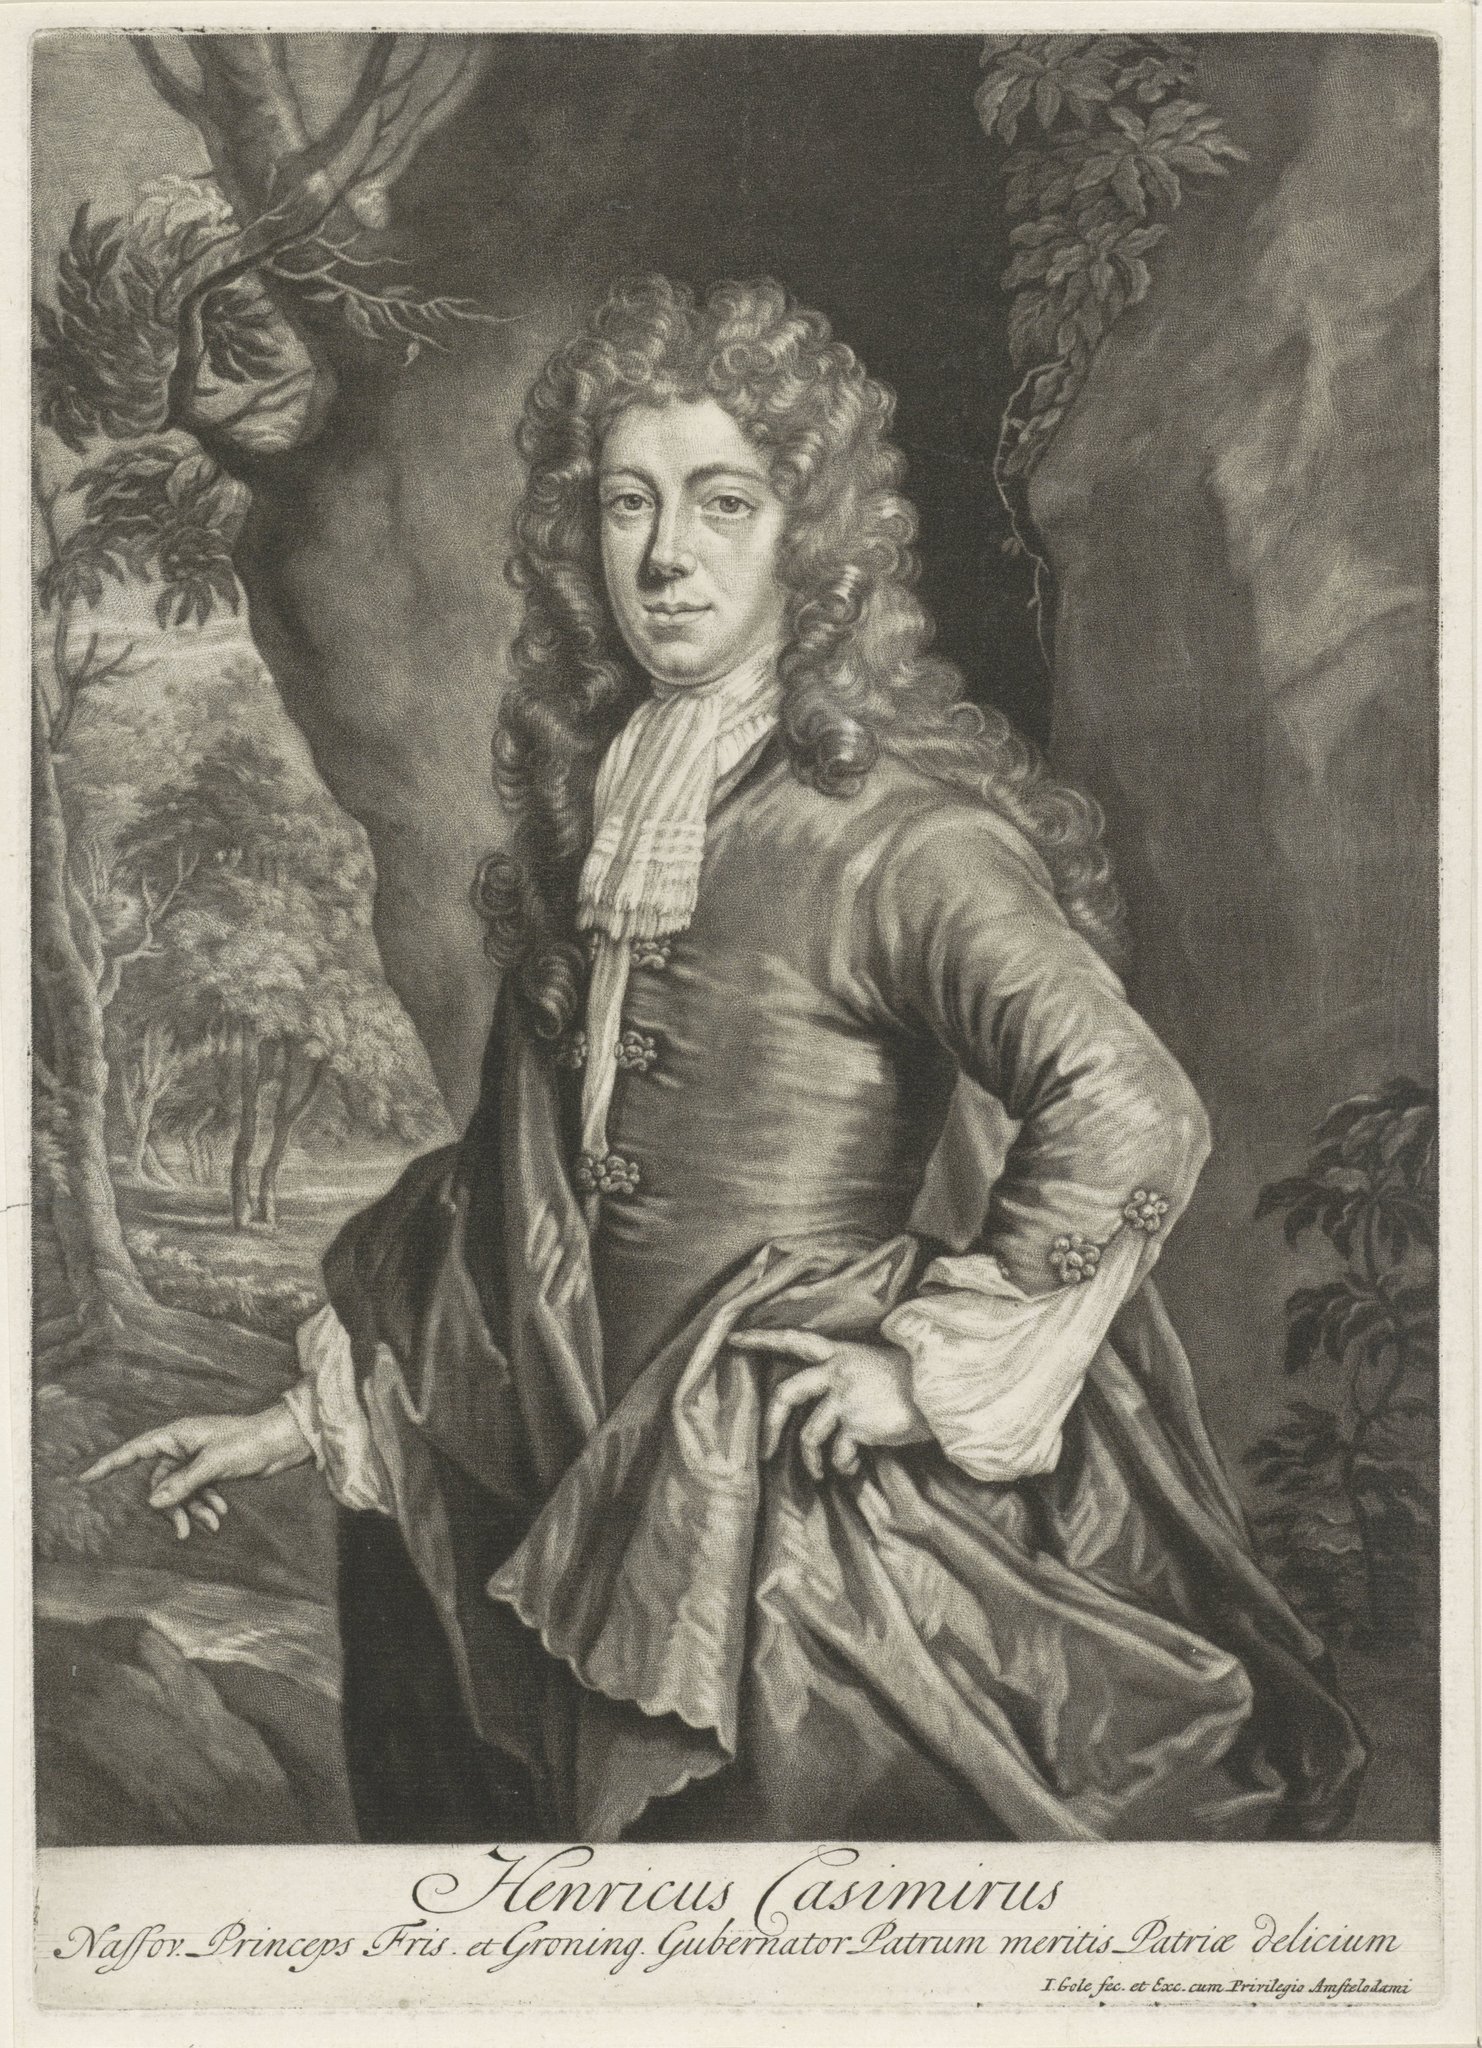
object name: print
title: Portret van Hendrik Casimir II, graaf van Nassau-Dietz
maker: jacob gole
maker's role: print maker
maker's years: 1660-1724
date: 1681-1724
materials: paper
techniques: mezzotint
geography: amsterdam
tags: the hague, hendrik casimir ii graaf van nassau-dietz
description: De hier vermelde titel verwijst naar de hoogst verkregen titel van de geportretteerde, niet per se naar de titel die de geportretteerde op deze voorstelling draagt.